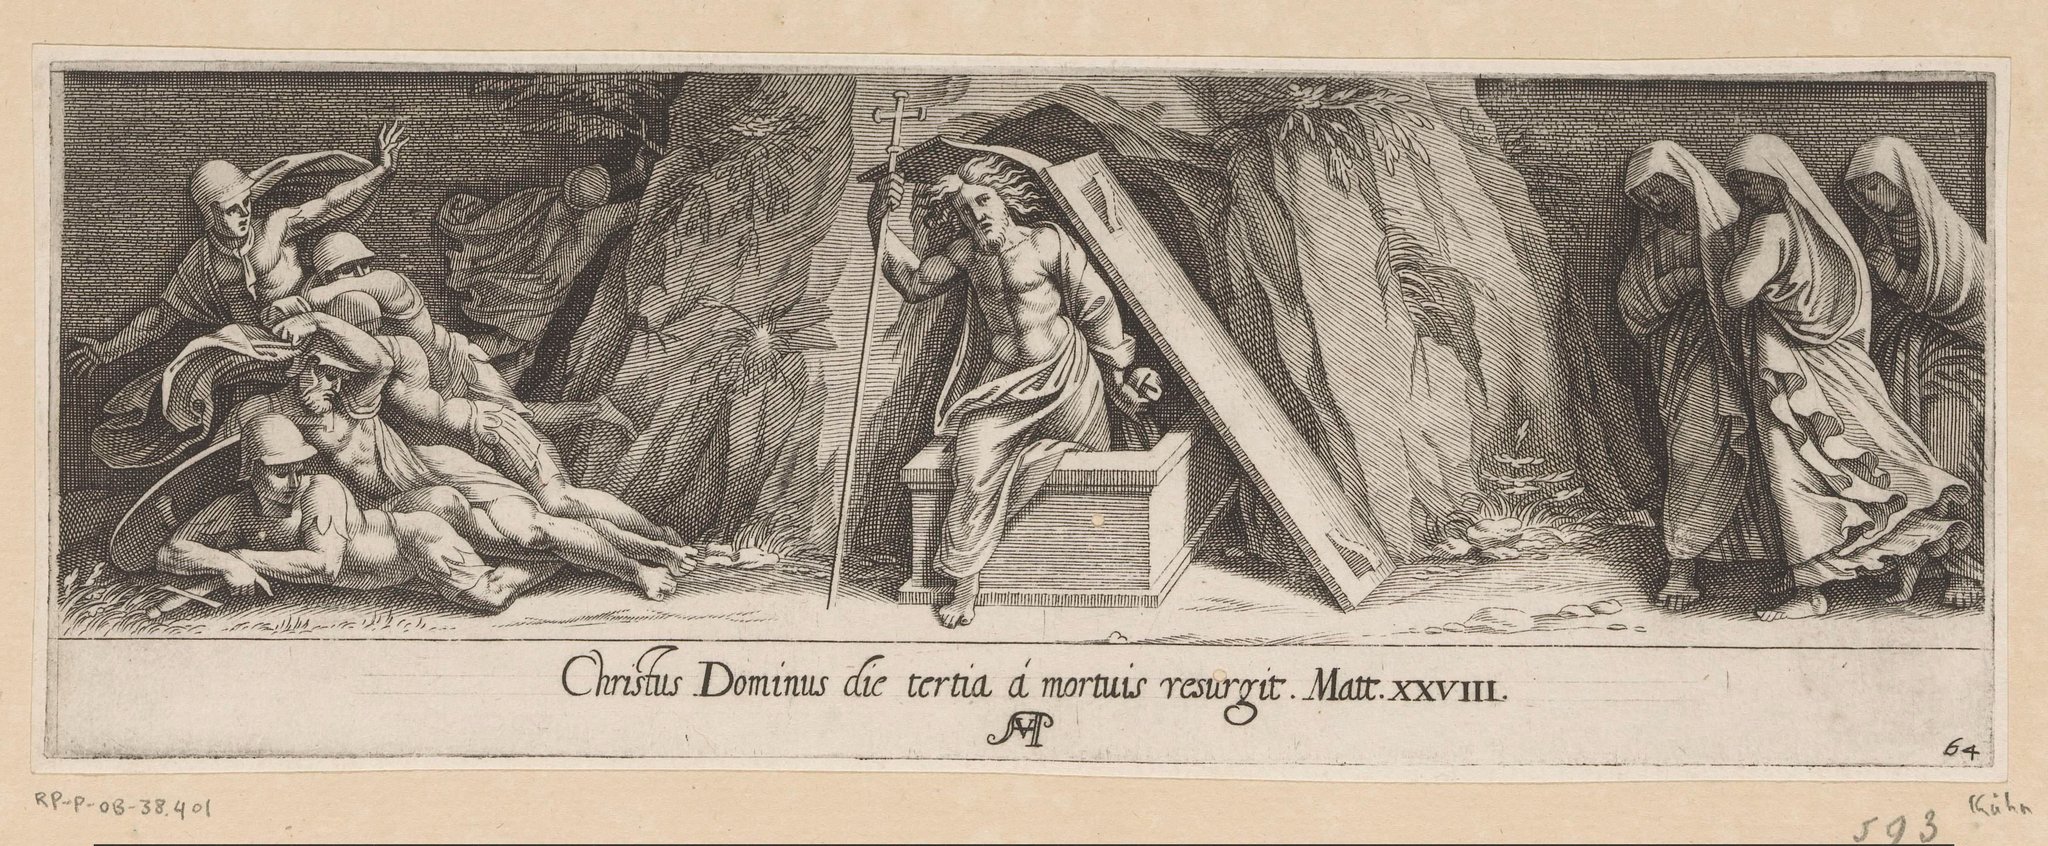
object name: print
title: Opstanding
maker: francesco villamena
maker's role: draughtsman, painter, print maker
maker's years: 1566-1624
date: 1626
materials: paper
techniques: engraving, etching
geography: vatican city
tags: christ, usually holding a banner, arises from the grave; often combined with sleeping and/or frightened soldiers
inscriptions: collector's mark: Lugt 240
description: Deze prent maakt deel uit van een serie bestaande uit een titelprent en twintig prenten door Francesco Villamena naar schilderingen in de Loggia van Rafaël in het Vaticaan. De serie werd na de dood van Villamena gepubliceerd. Terwijl de eerste vijftien prenten 1-15 zijn genummerd, zijn de laatste vijf prenten genummerd 60-64. Mogelijk had de prentmaker een serie van 64 prenten voor ogen, die vanwege zijn dood onvoltooid bleef.